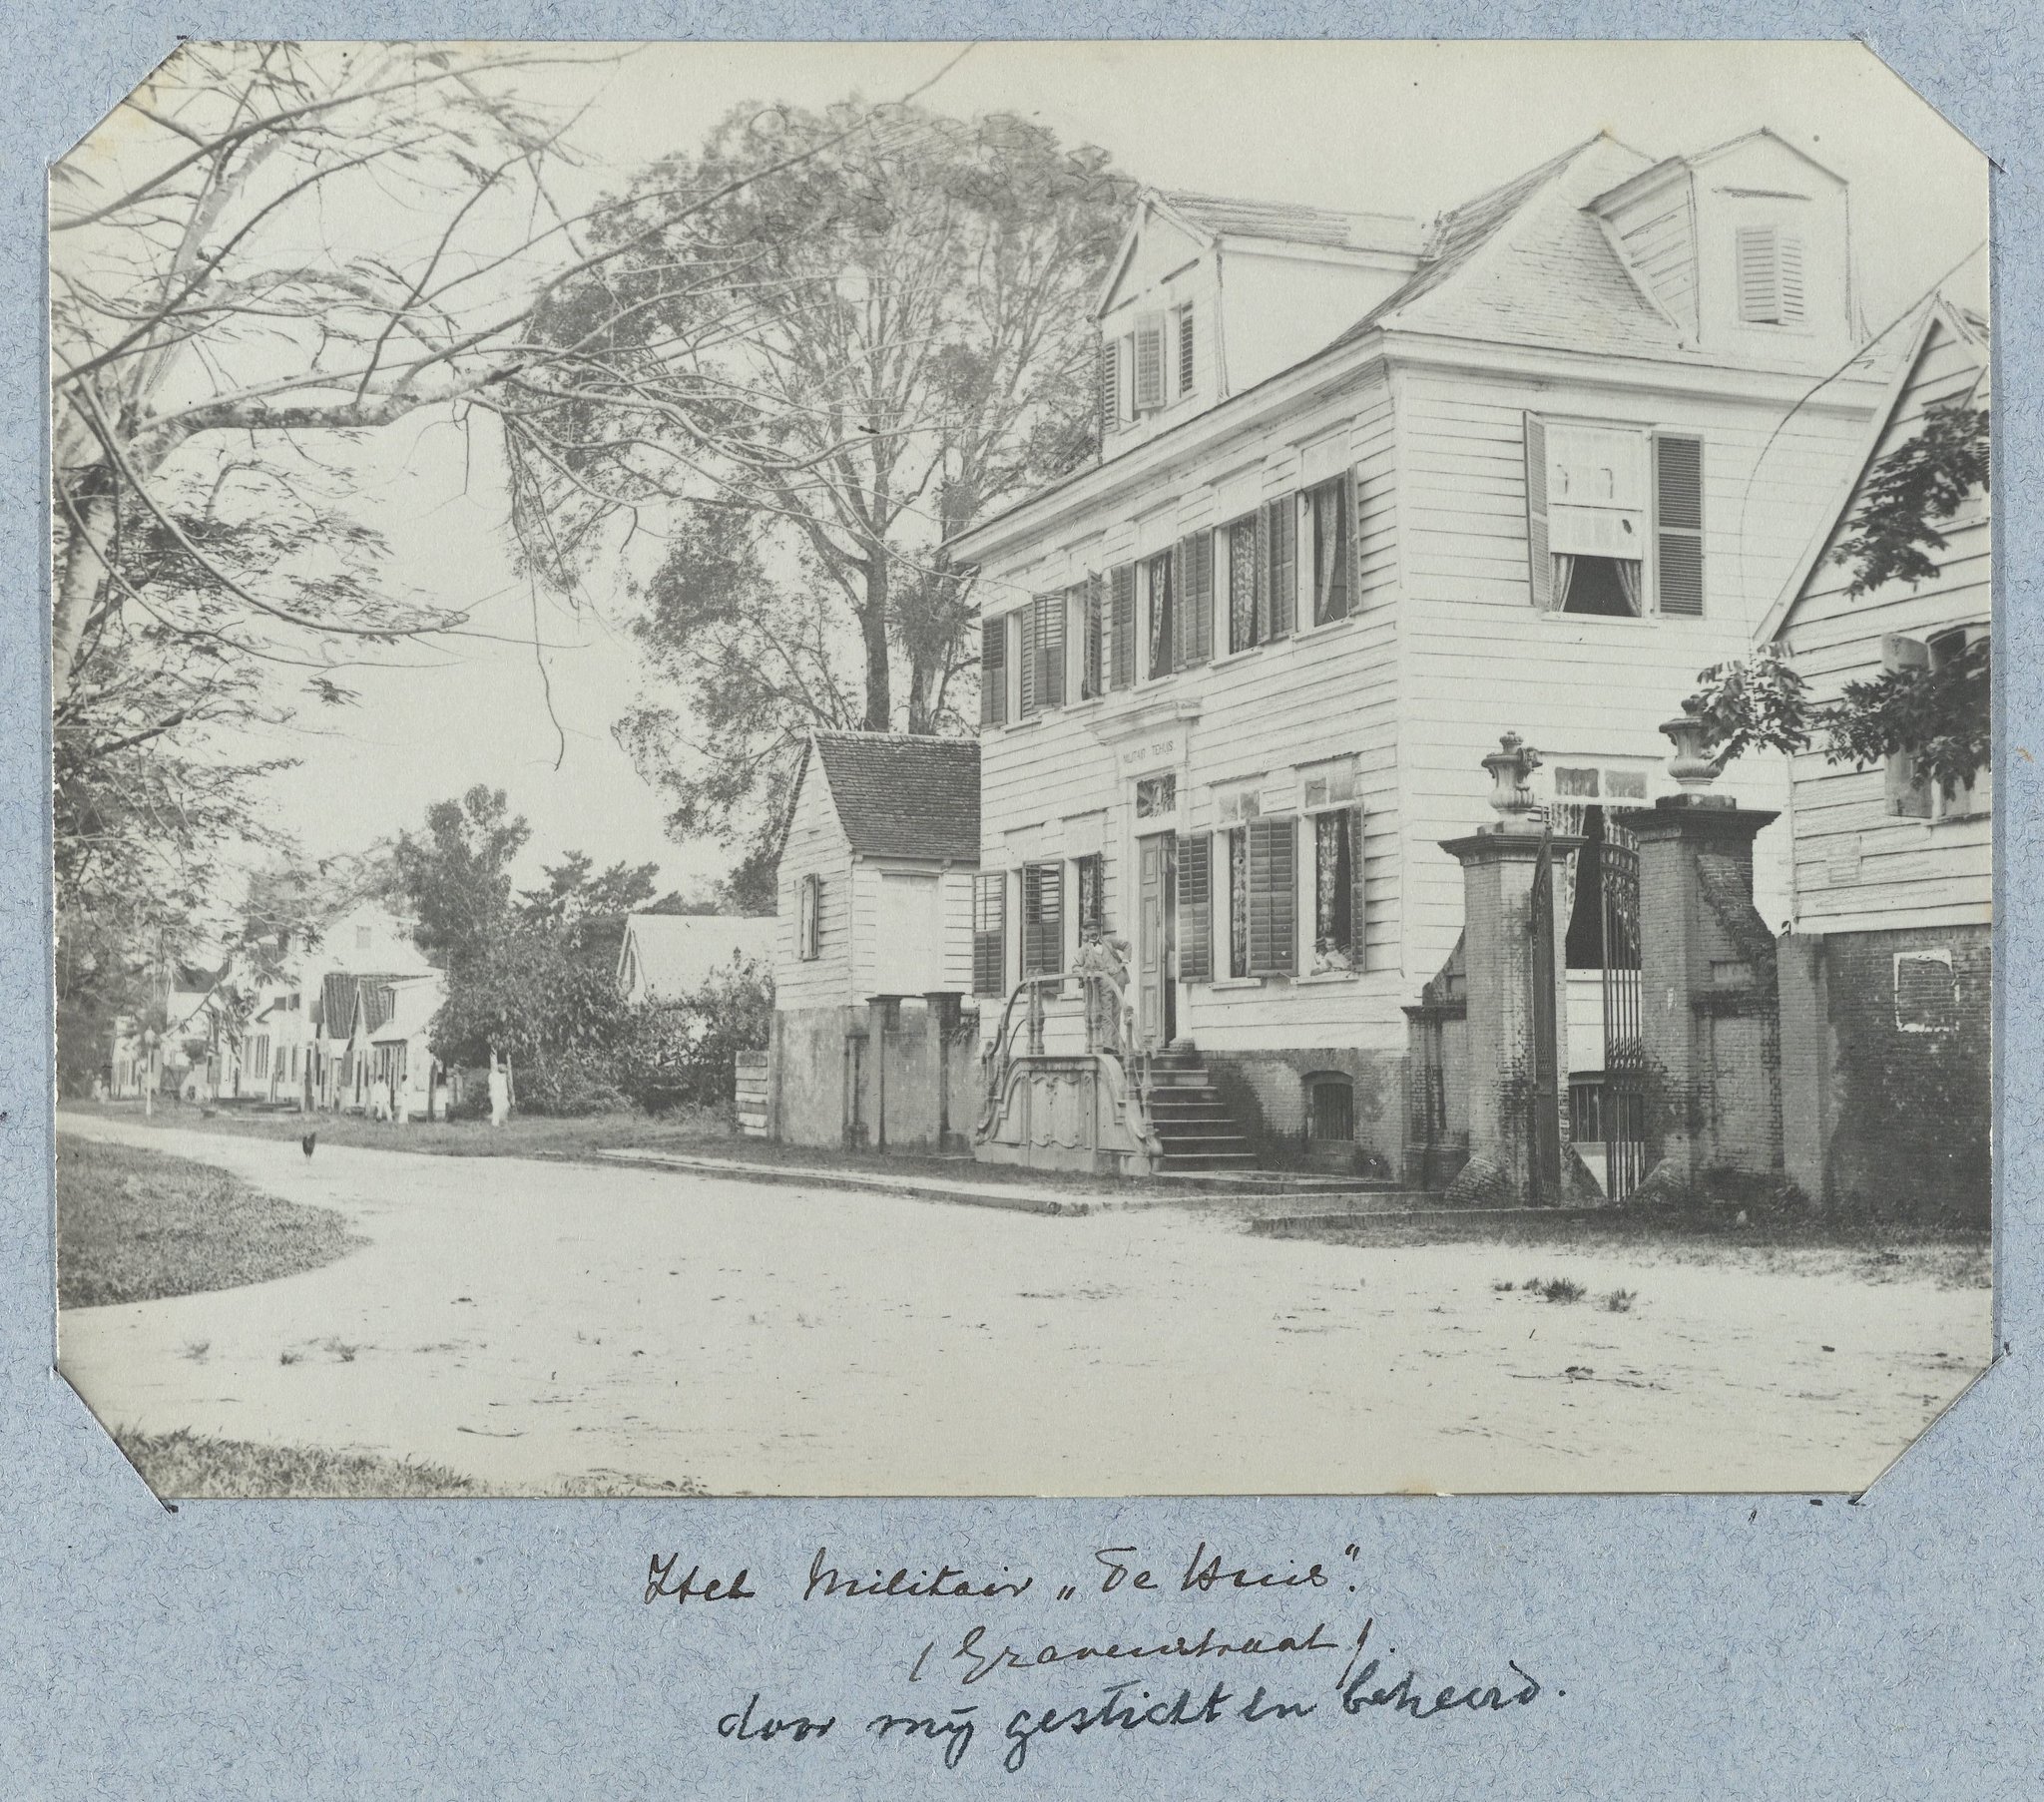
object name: photograph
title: Het Militair "Te Huis" (Gravenstraat)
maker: théodore van lelyveld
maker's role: painter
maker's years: 1867-1954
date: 1895-1898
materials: photographic support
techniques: gelatin silver print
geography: suriname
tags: old-soldiers-home, 'hôtel des invalides'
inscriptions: inscription: ‘Het Militair "Te Huis" (Gravenstraat)./ door mij gesticht en beheerd.’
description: Gezicht op het Militair Tehuis gelegen aan de Gravenstraat te Paramaribo. Volgens het onderschrift door Lelyveld gesticht en beheerd. Fotoafdruk in een fotoalbum van Théodore van Lelyveld over Suriname uit 1895-1898.